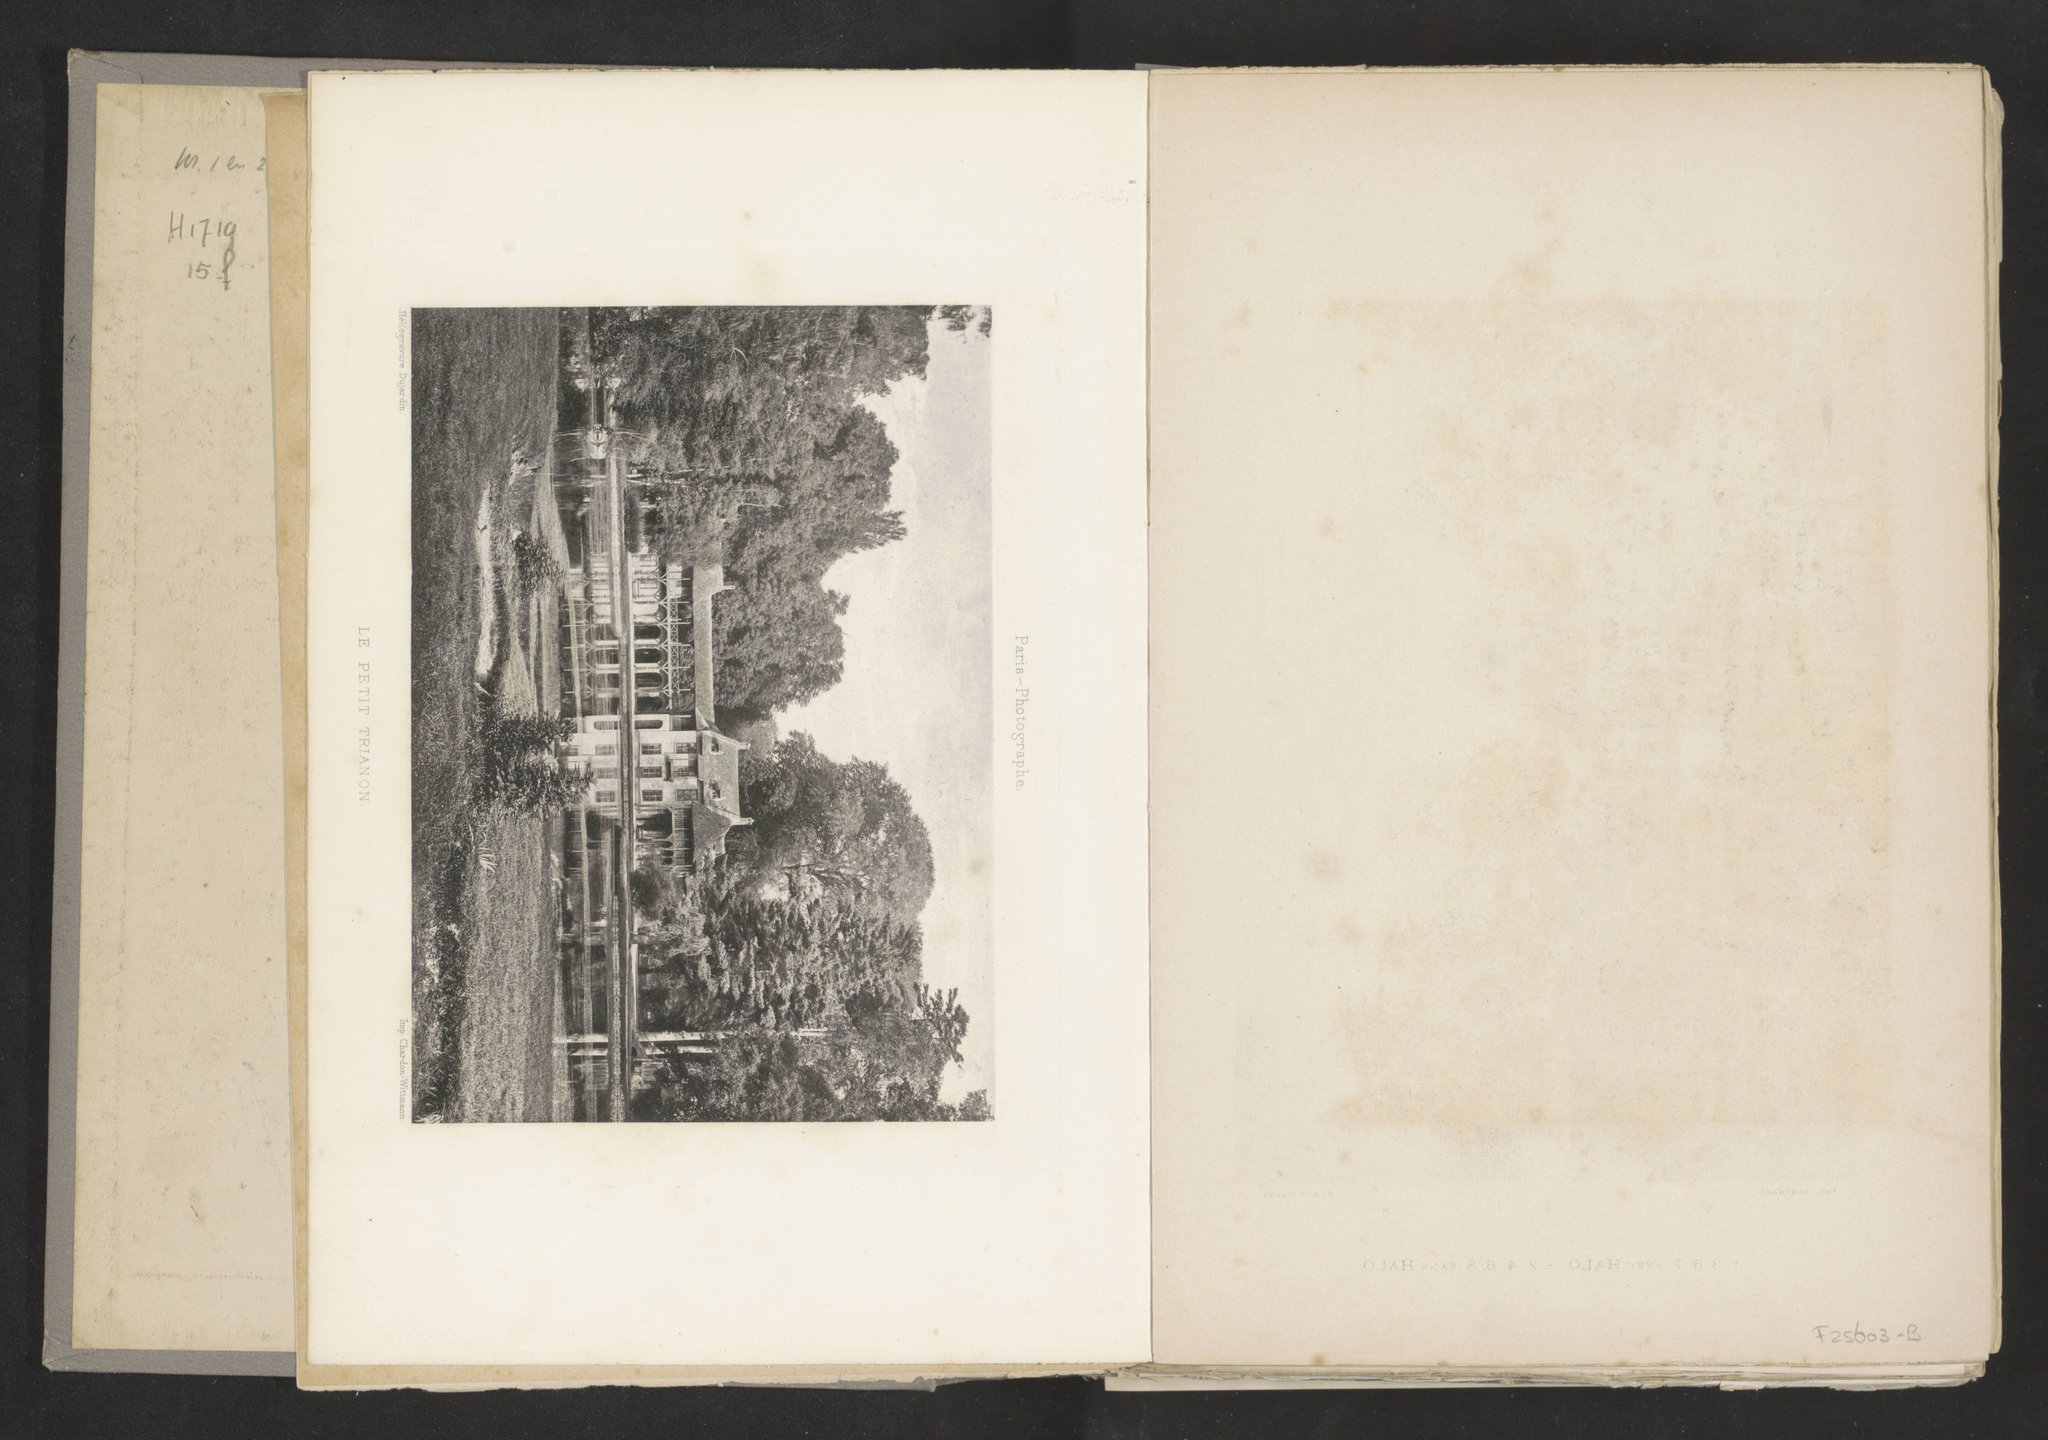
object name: page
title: Le Petit Trianon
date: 1881-1891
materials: paper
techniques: photoaquatint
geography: france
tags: architectural folly, village, farm (building)